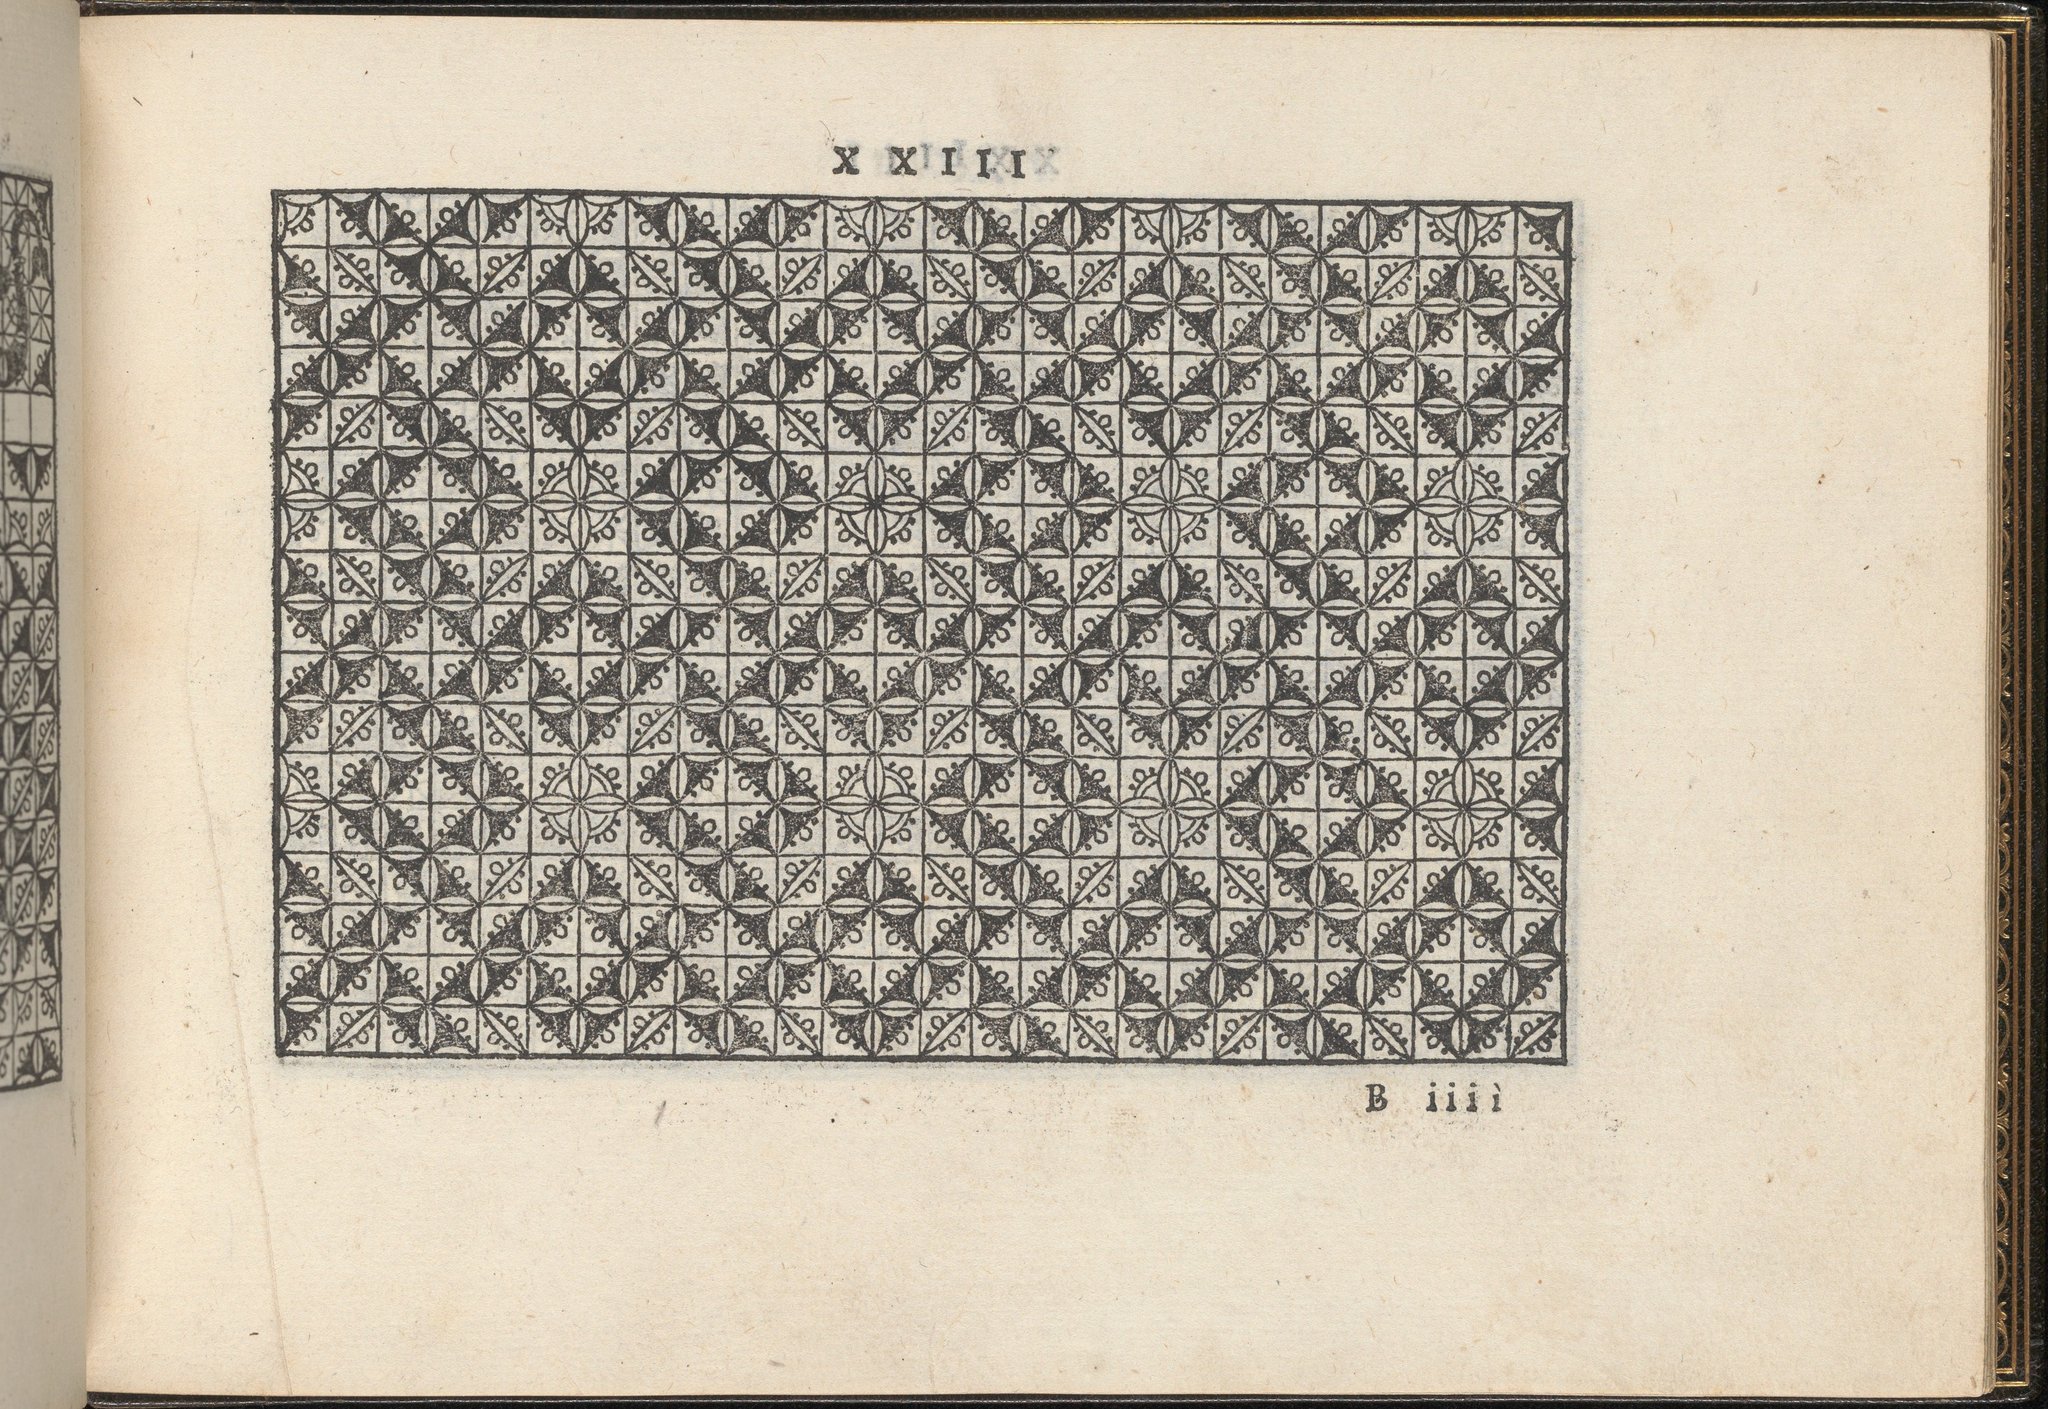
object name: book print ornament architecture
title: La Vera Perfettione del Disegno di varie sorti di recami, page 12 (recto)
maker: giovanni ostaus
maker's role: publisher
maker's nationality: italian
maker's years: 1507-1607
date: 1567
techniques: woodcut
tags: ornament